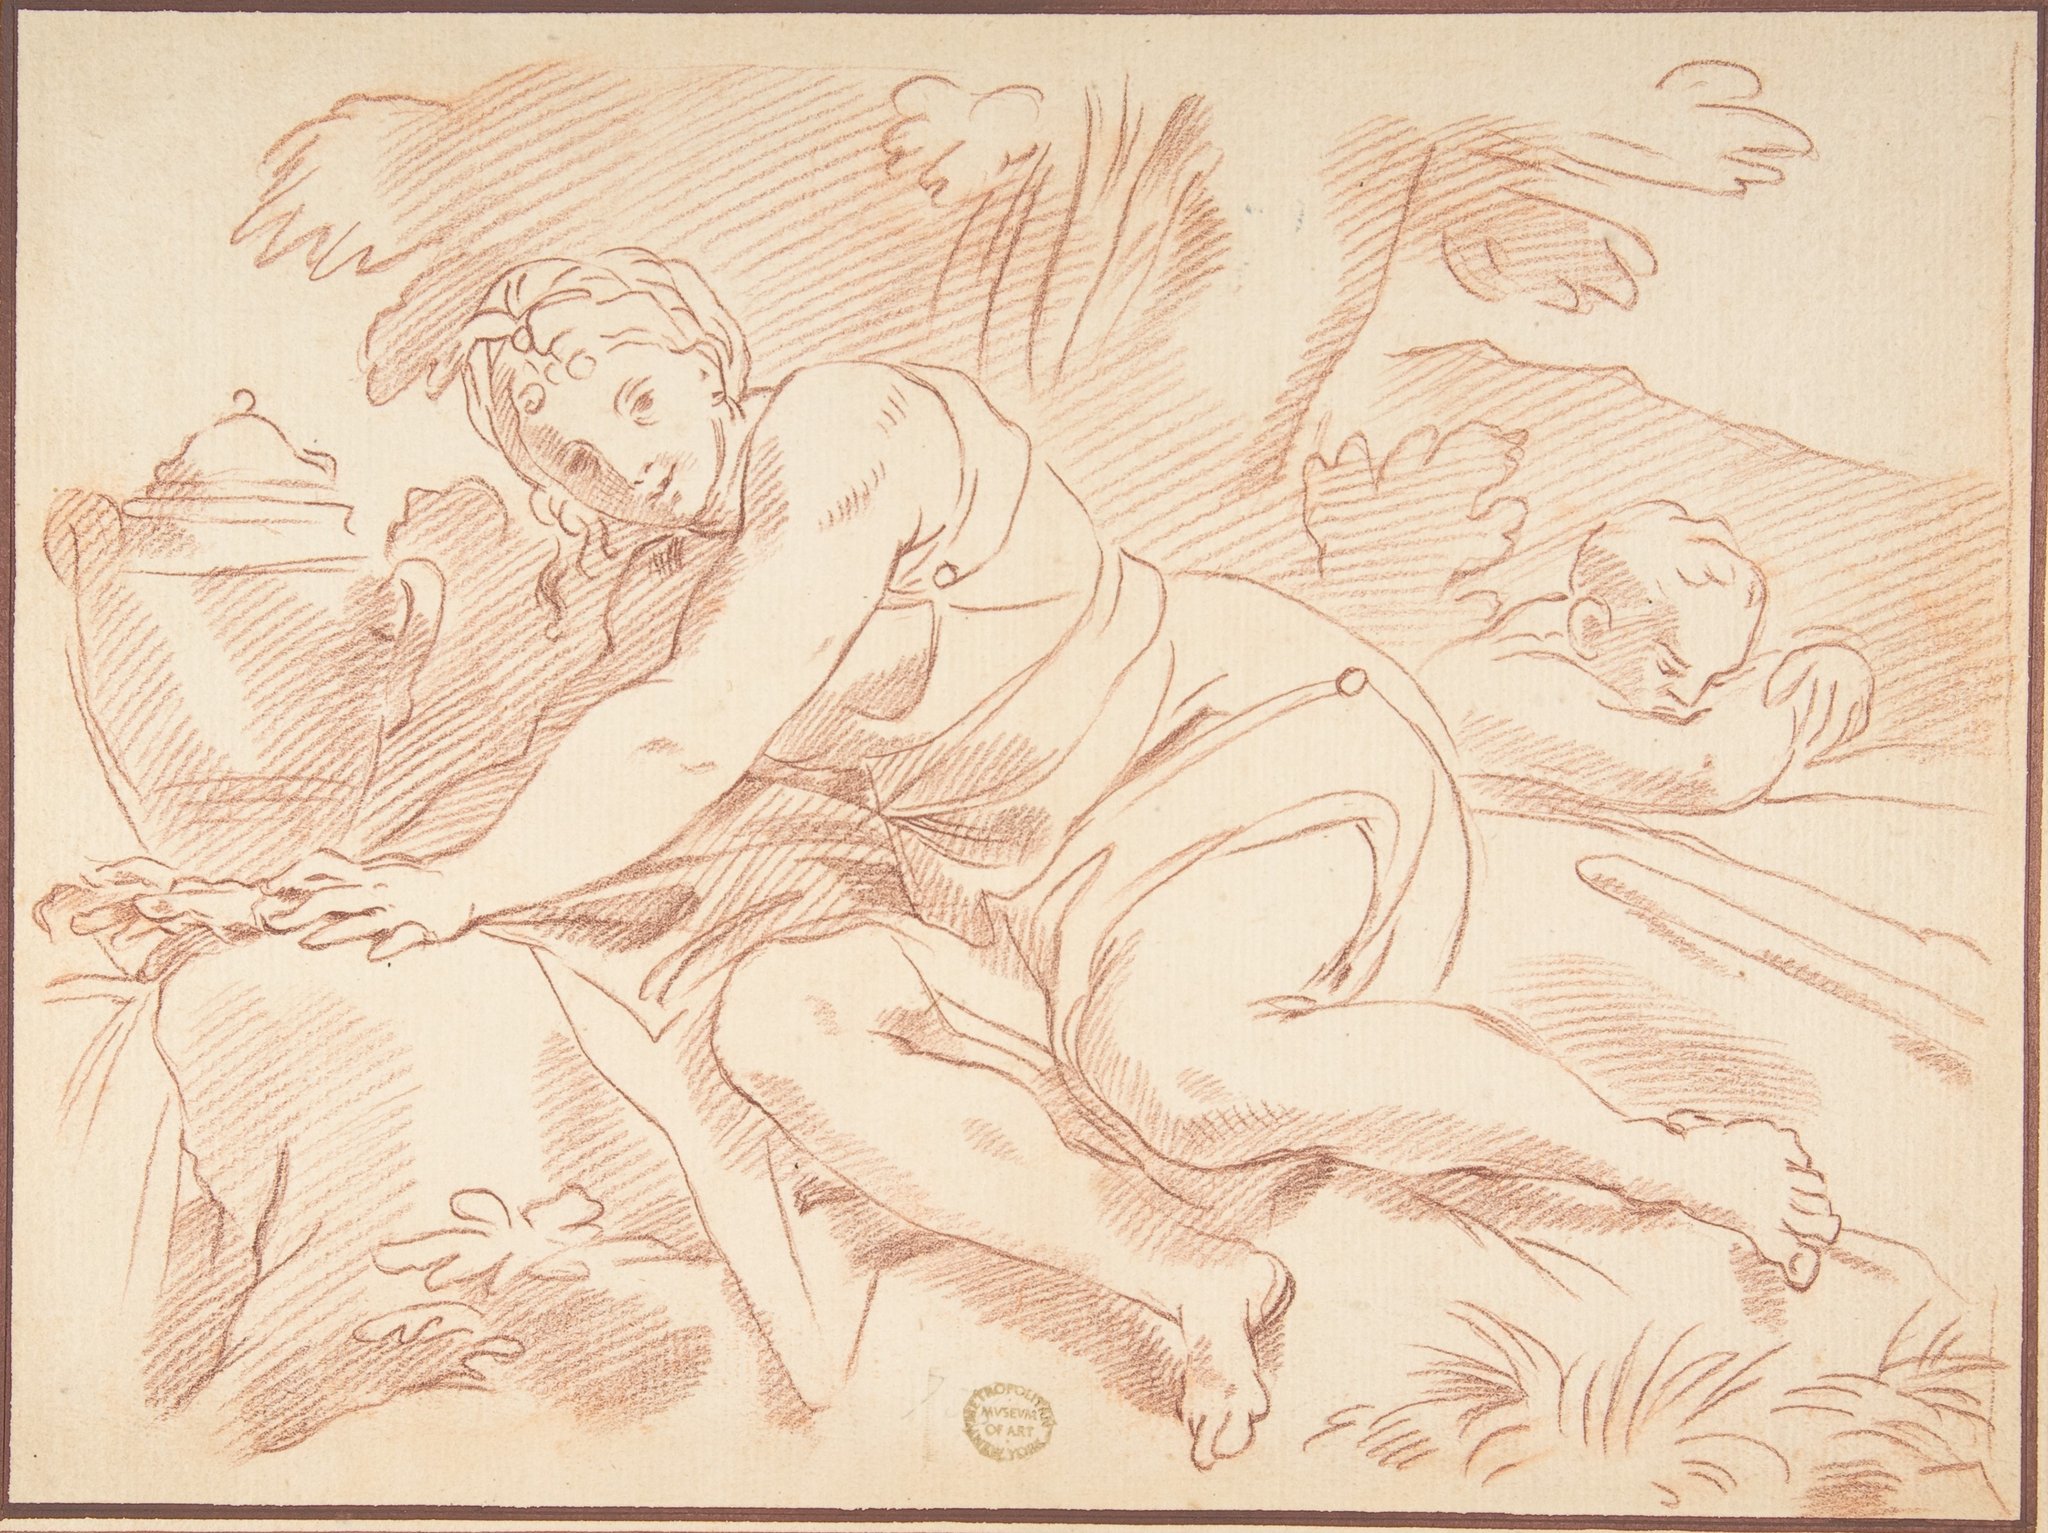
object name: drawing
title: Nymph and Cupid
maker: anonymous, italian, roman-bolognese, 17th century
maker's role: artist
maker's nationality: italian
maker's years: 1600-1700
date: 1601-1700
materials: chalk, paper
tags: cupid,nymphs